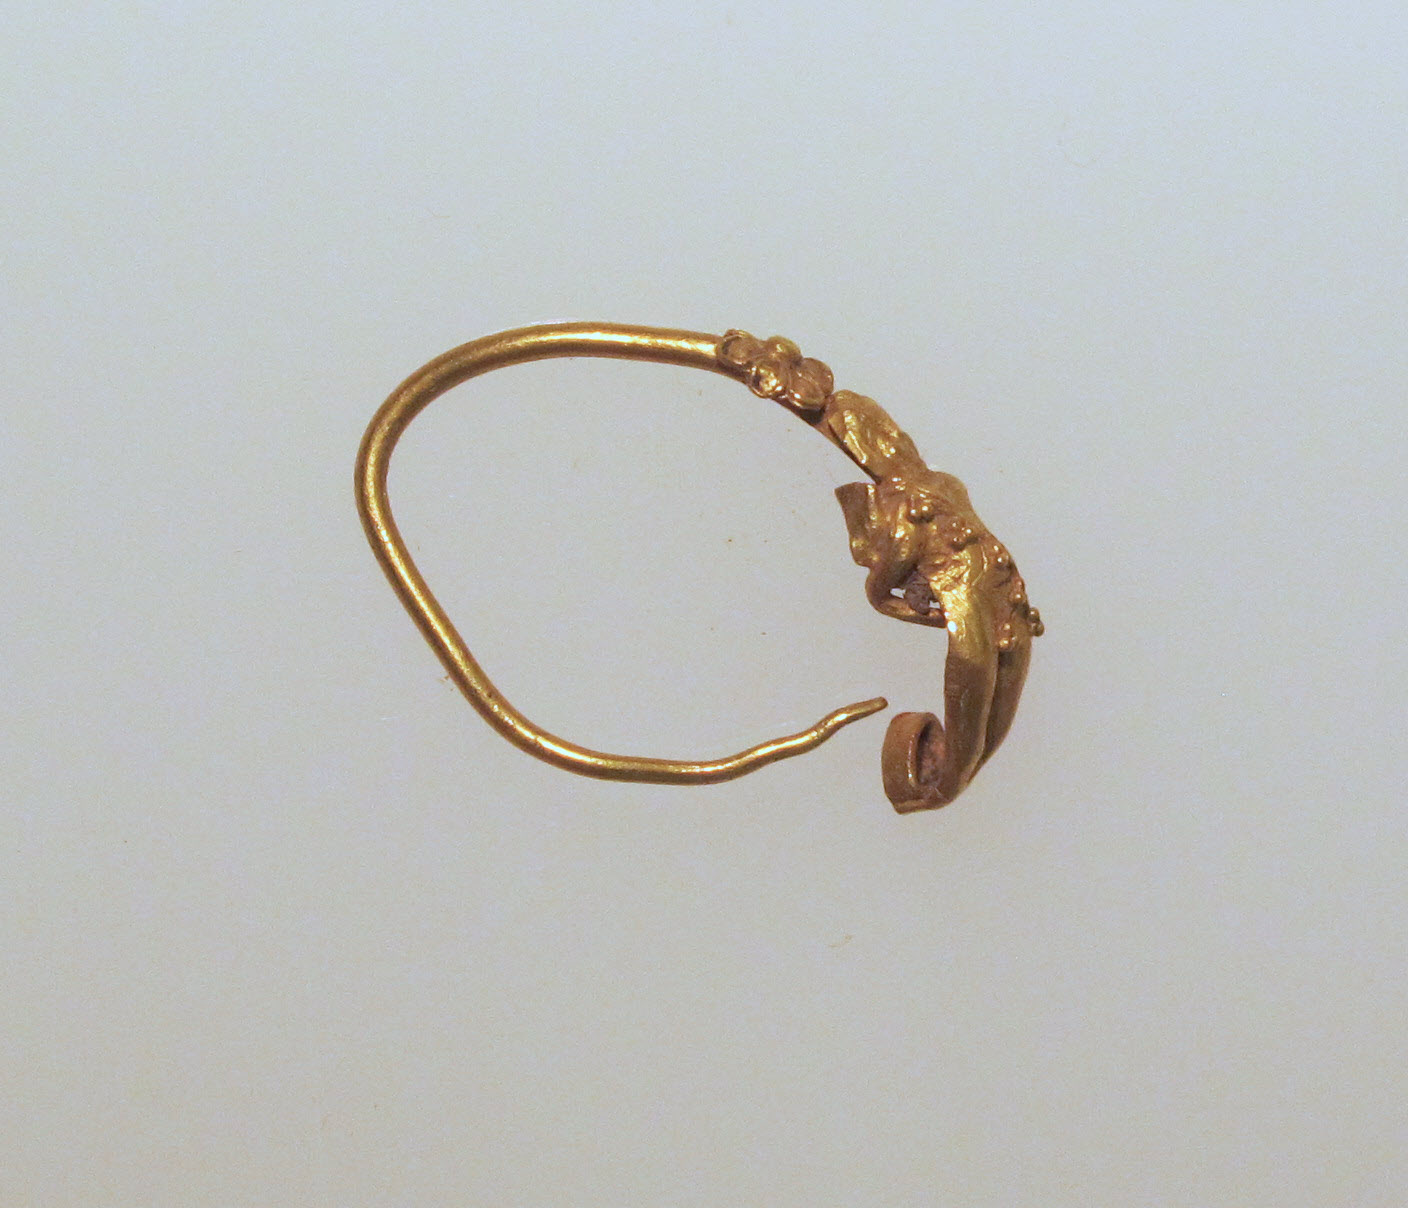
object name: earring with eros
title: Gold earring with figure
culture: greek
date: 300-101 BCE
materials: gold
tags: human figures